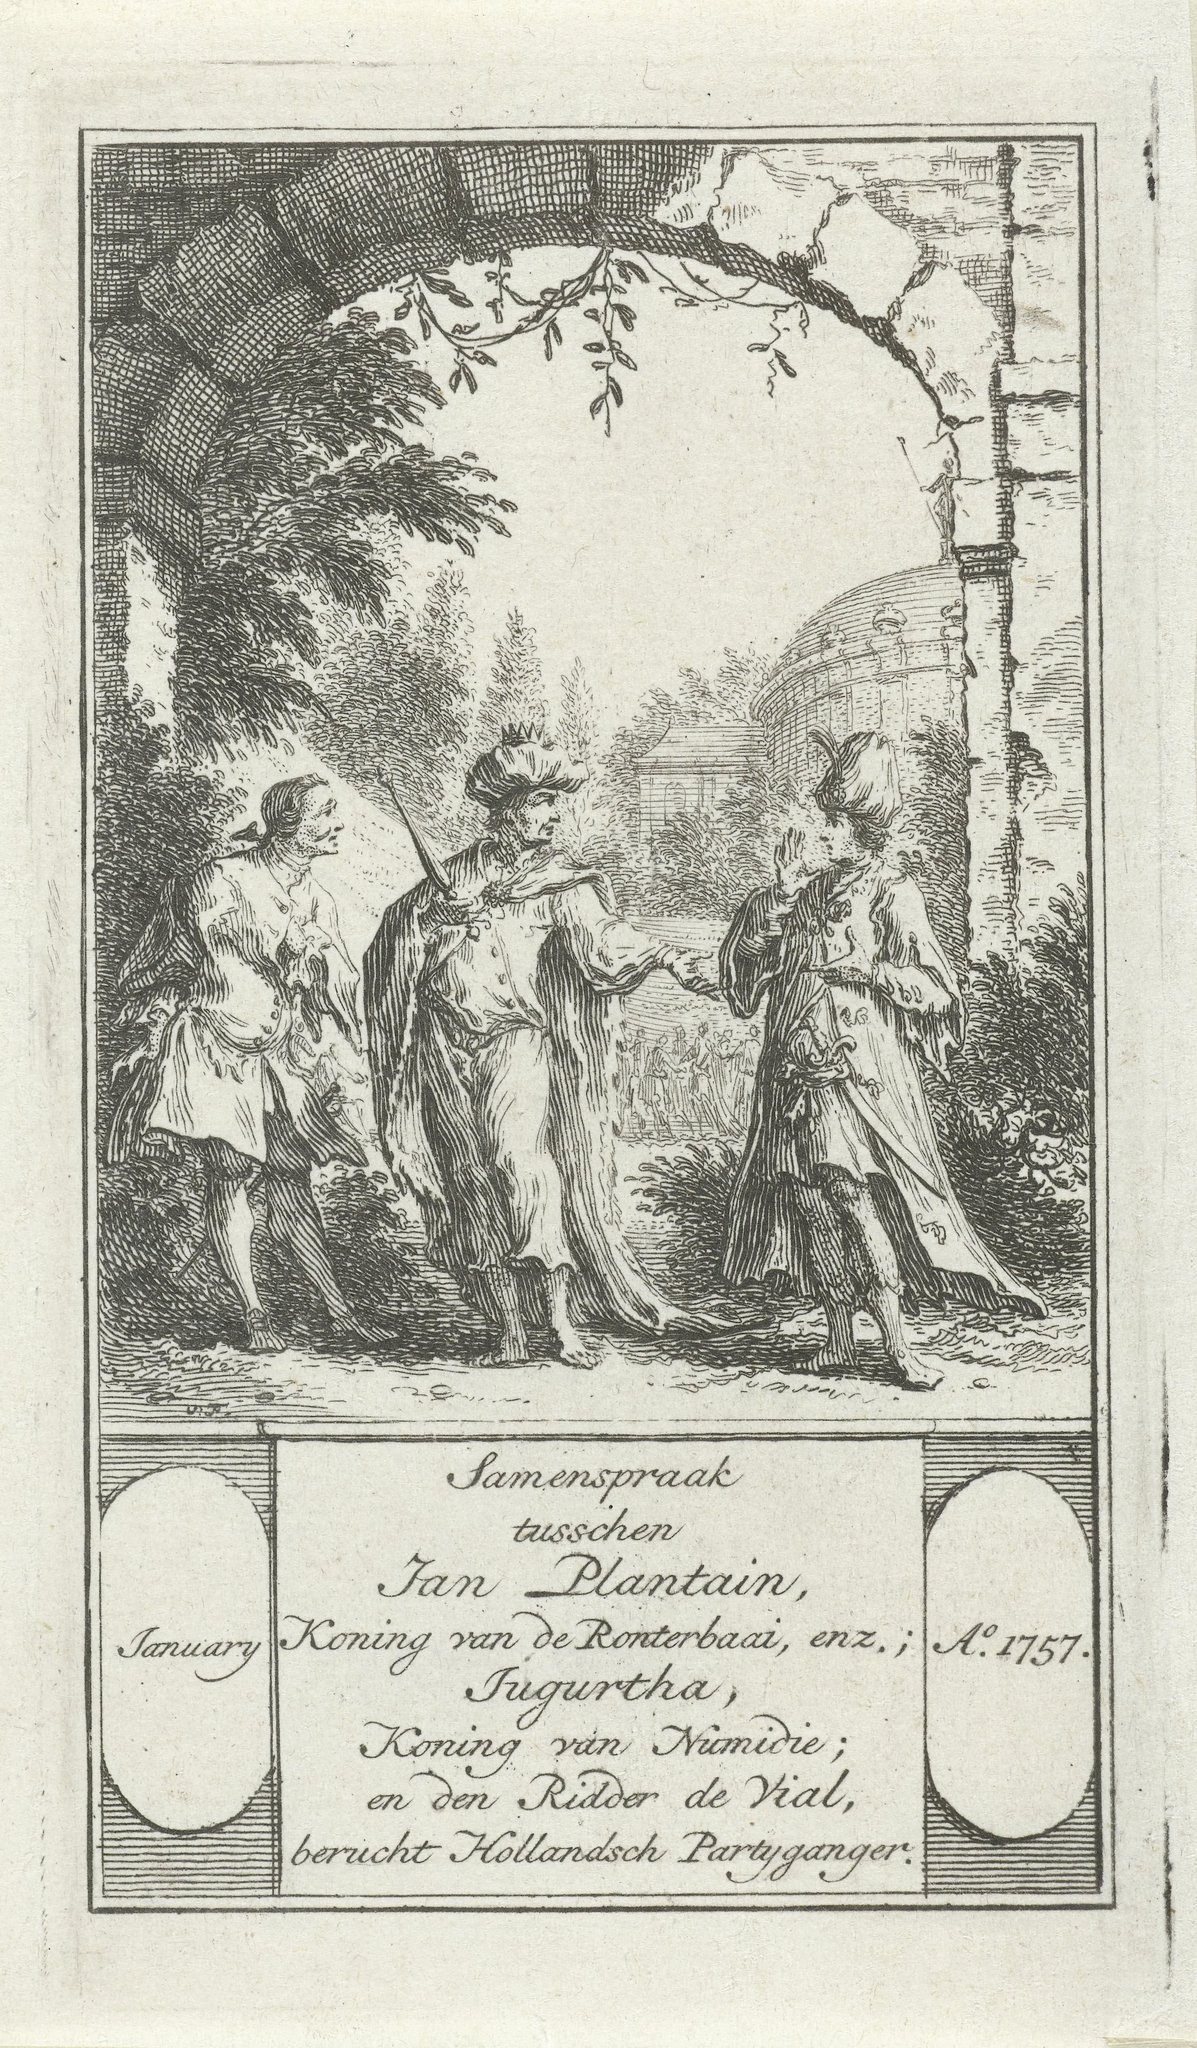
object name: book illustration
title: Illustraties vaderlandse geschiedenis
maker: simon fokke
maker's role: draughtsman, print maker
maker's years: 1712-1784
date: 1722-1784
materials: paper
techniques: etching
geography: amsterdam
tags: koning, jugurtha, breda, jean baptiste vial, jan plantain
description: Gesprek in de buitenlucht tussen Jan Plantain, Jugurtha en de Ridder de Vial. Onder de afbeelding een tekst met de datum januari 1757.